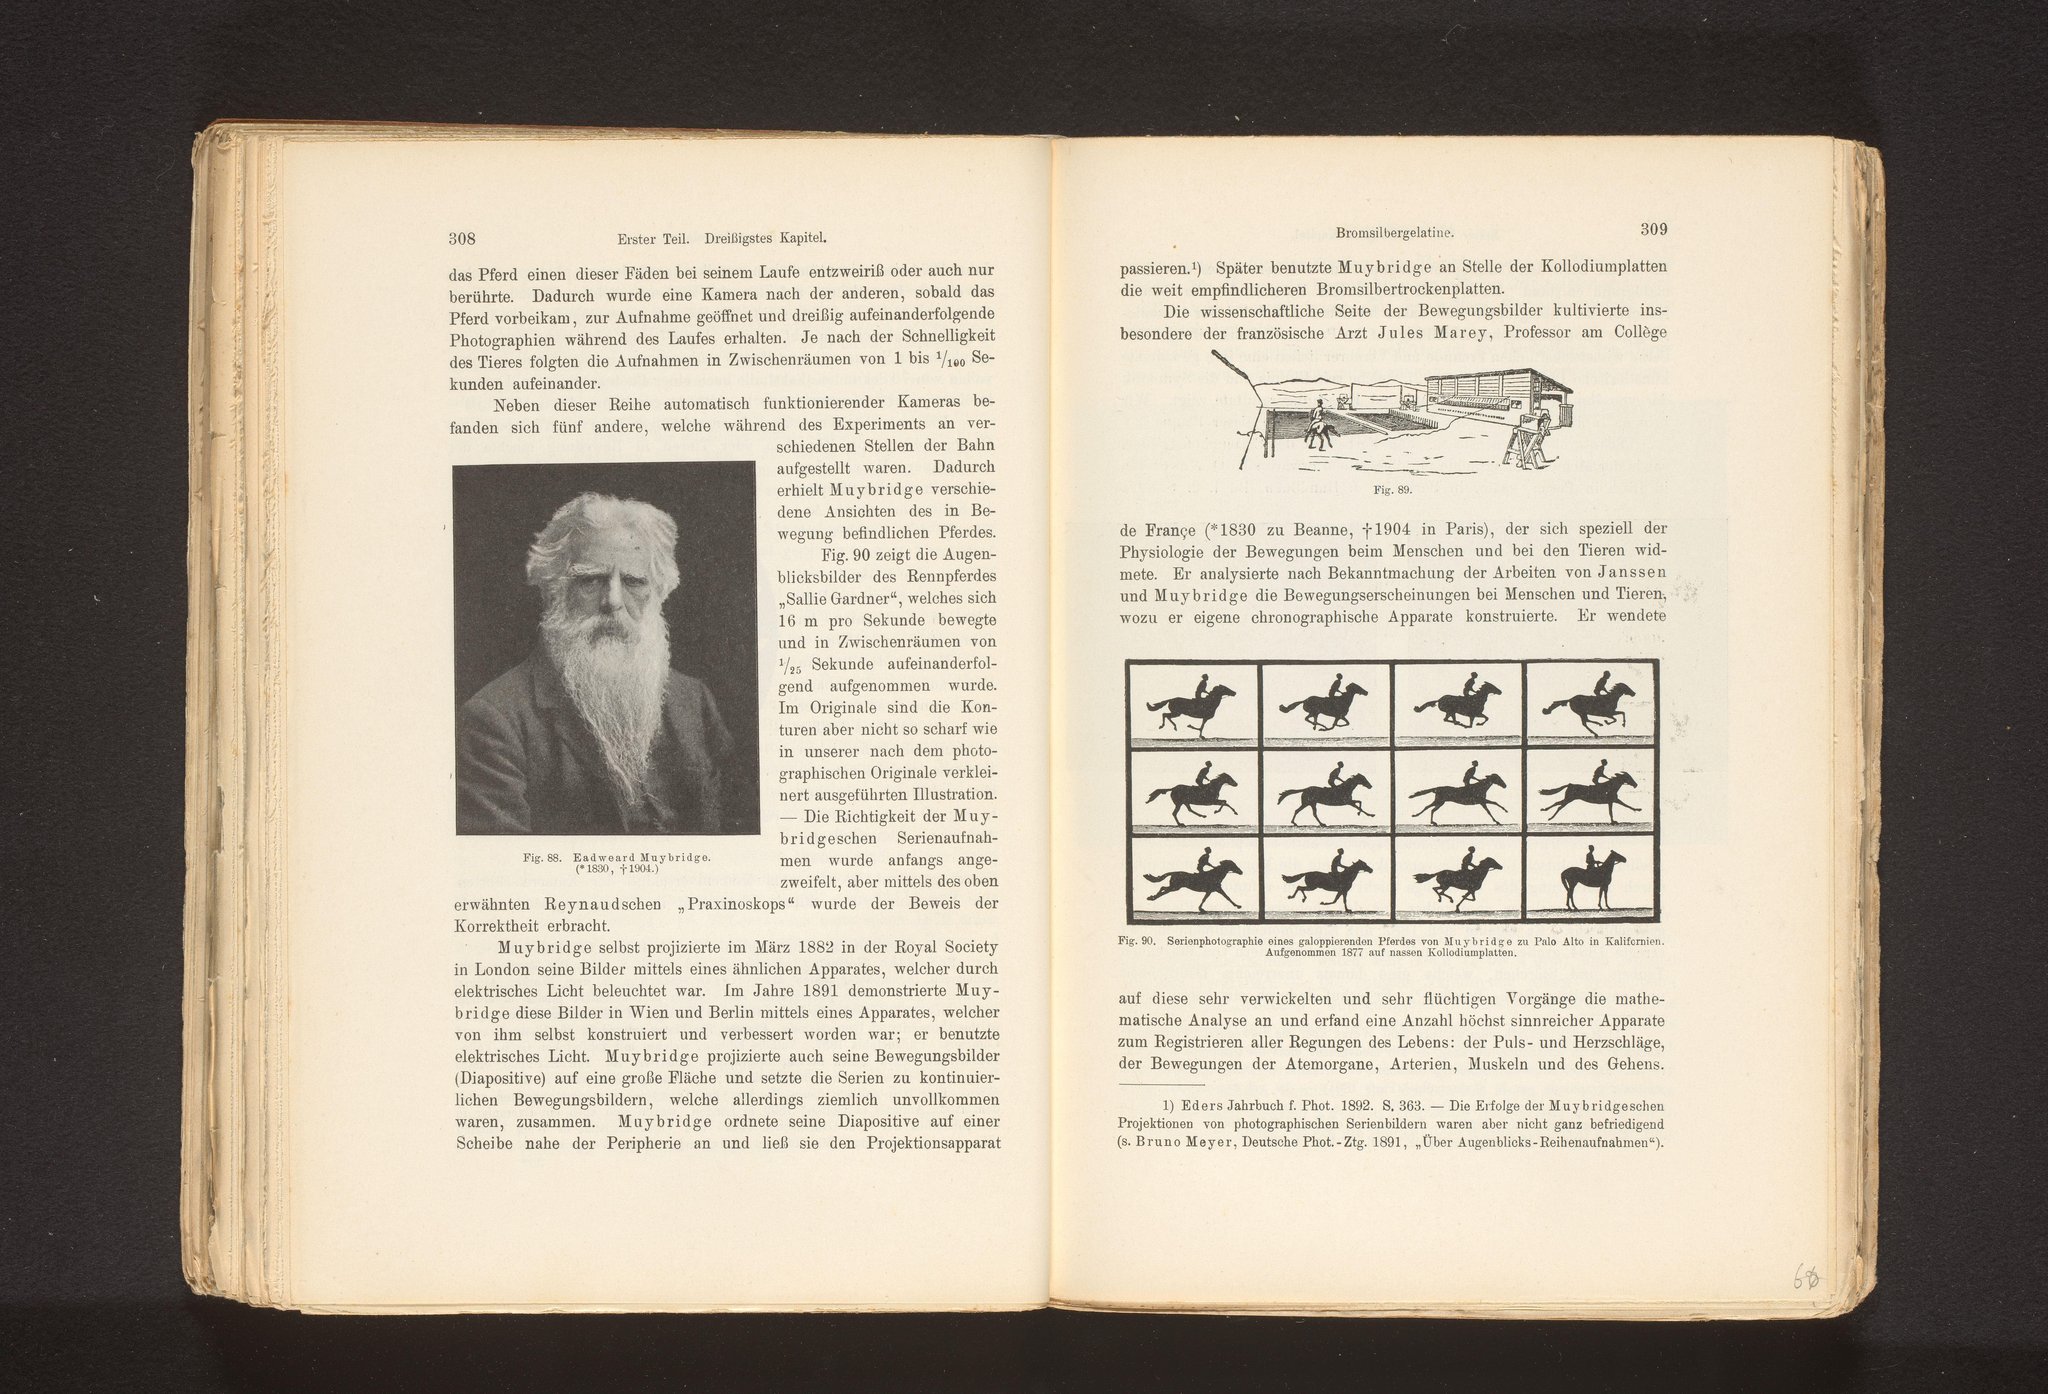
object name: page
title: Portret van Eadweard Muybridge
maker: Anonymous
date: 1900-1905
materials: paper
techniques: autotype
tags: eadweard muybridge, portrait, self-portrait of photographer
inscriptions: number: ‘Fig. 88.’